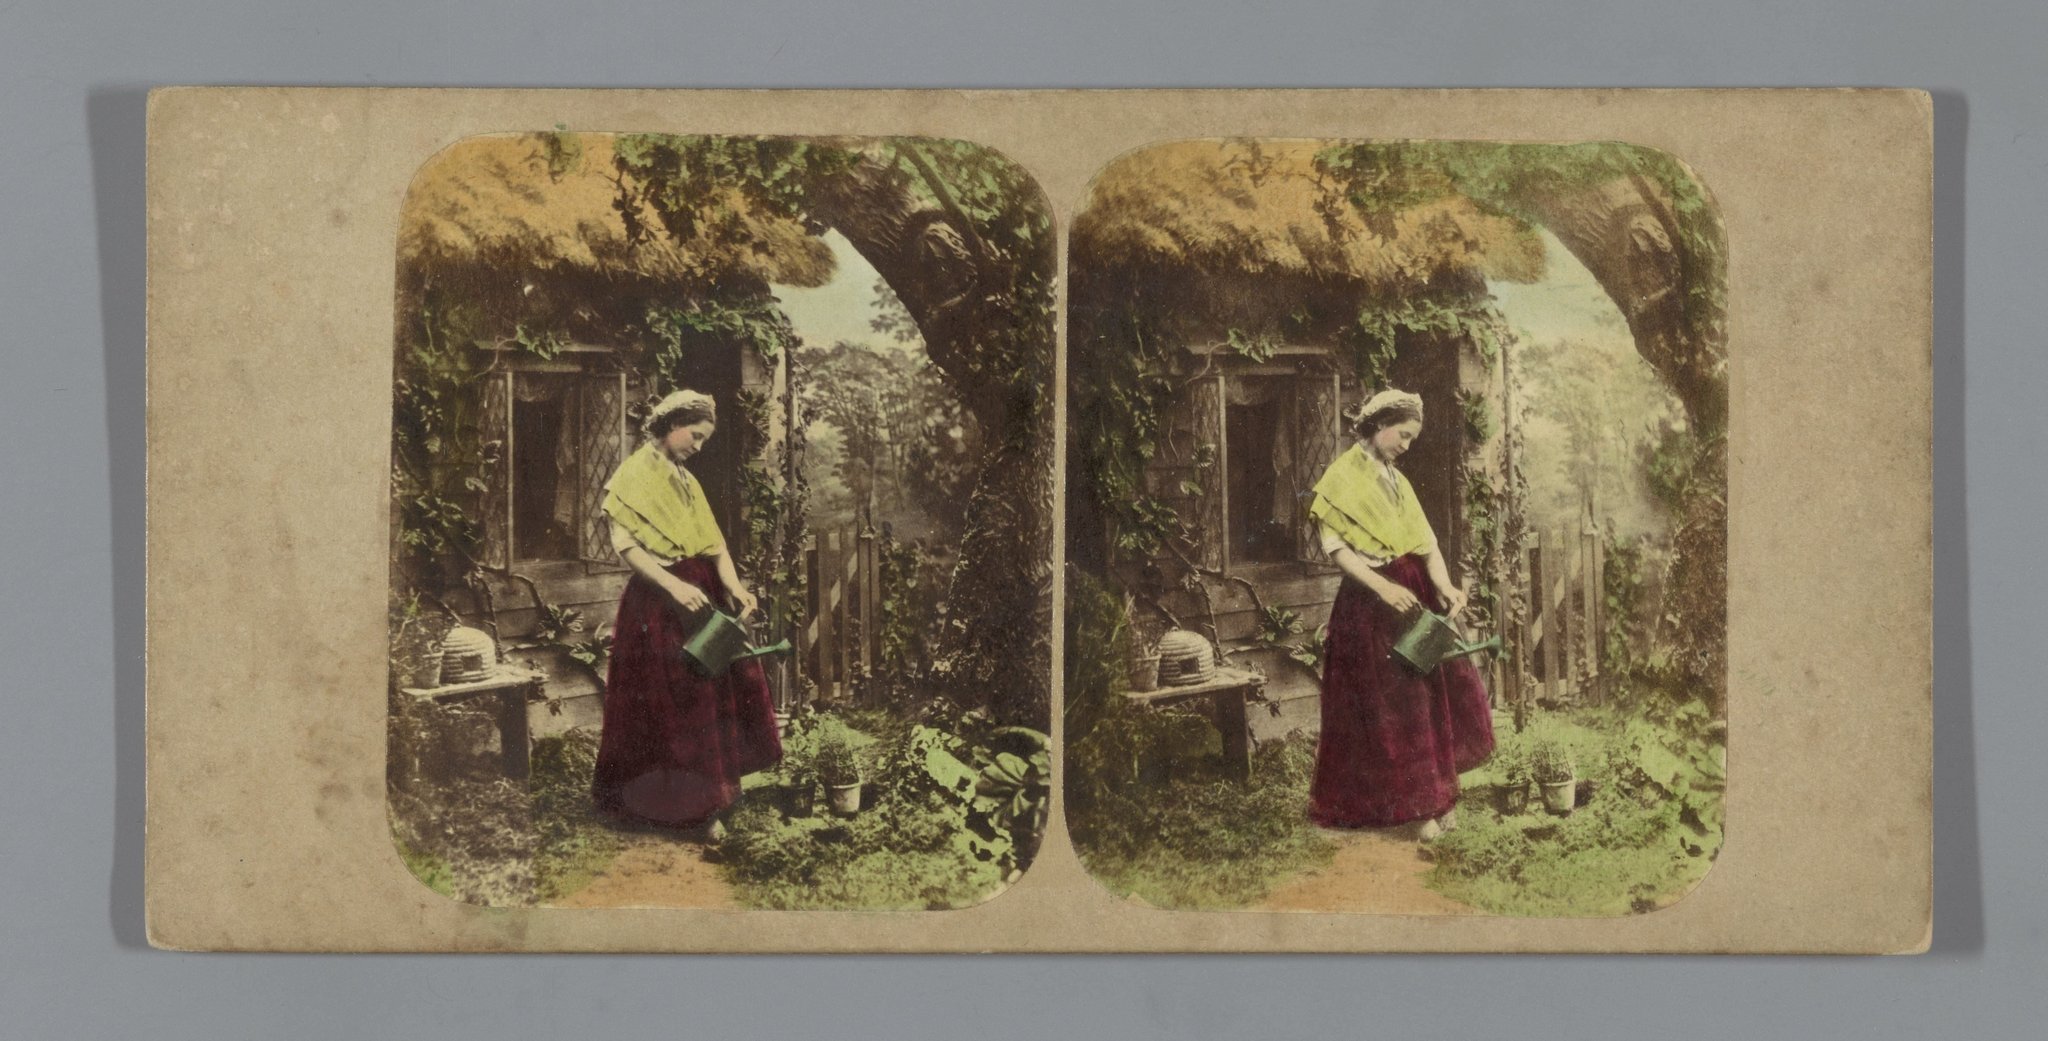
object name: stereograph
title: Vrouw begiet planten voor een cottage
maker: Anonymous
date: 1852-1863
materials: cardboard, paper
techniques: albumen print, hand coloring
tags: watering plants, cottage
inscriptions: inscription: ‘AL’